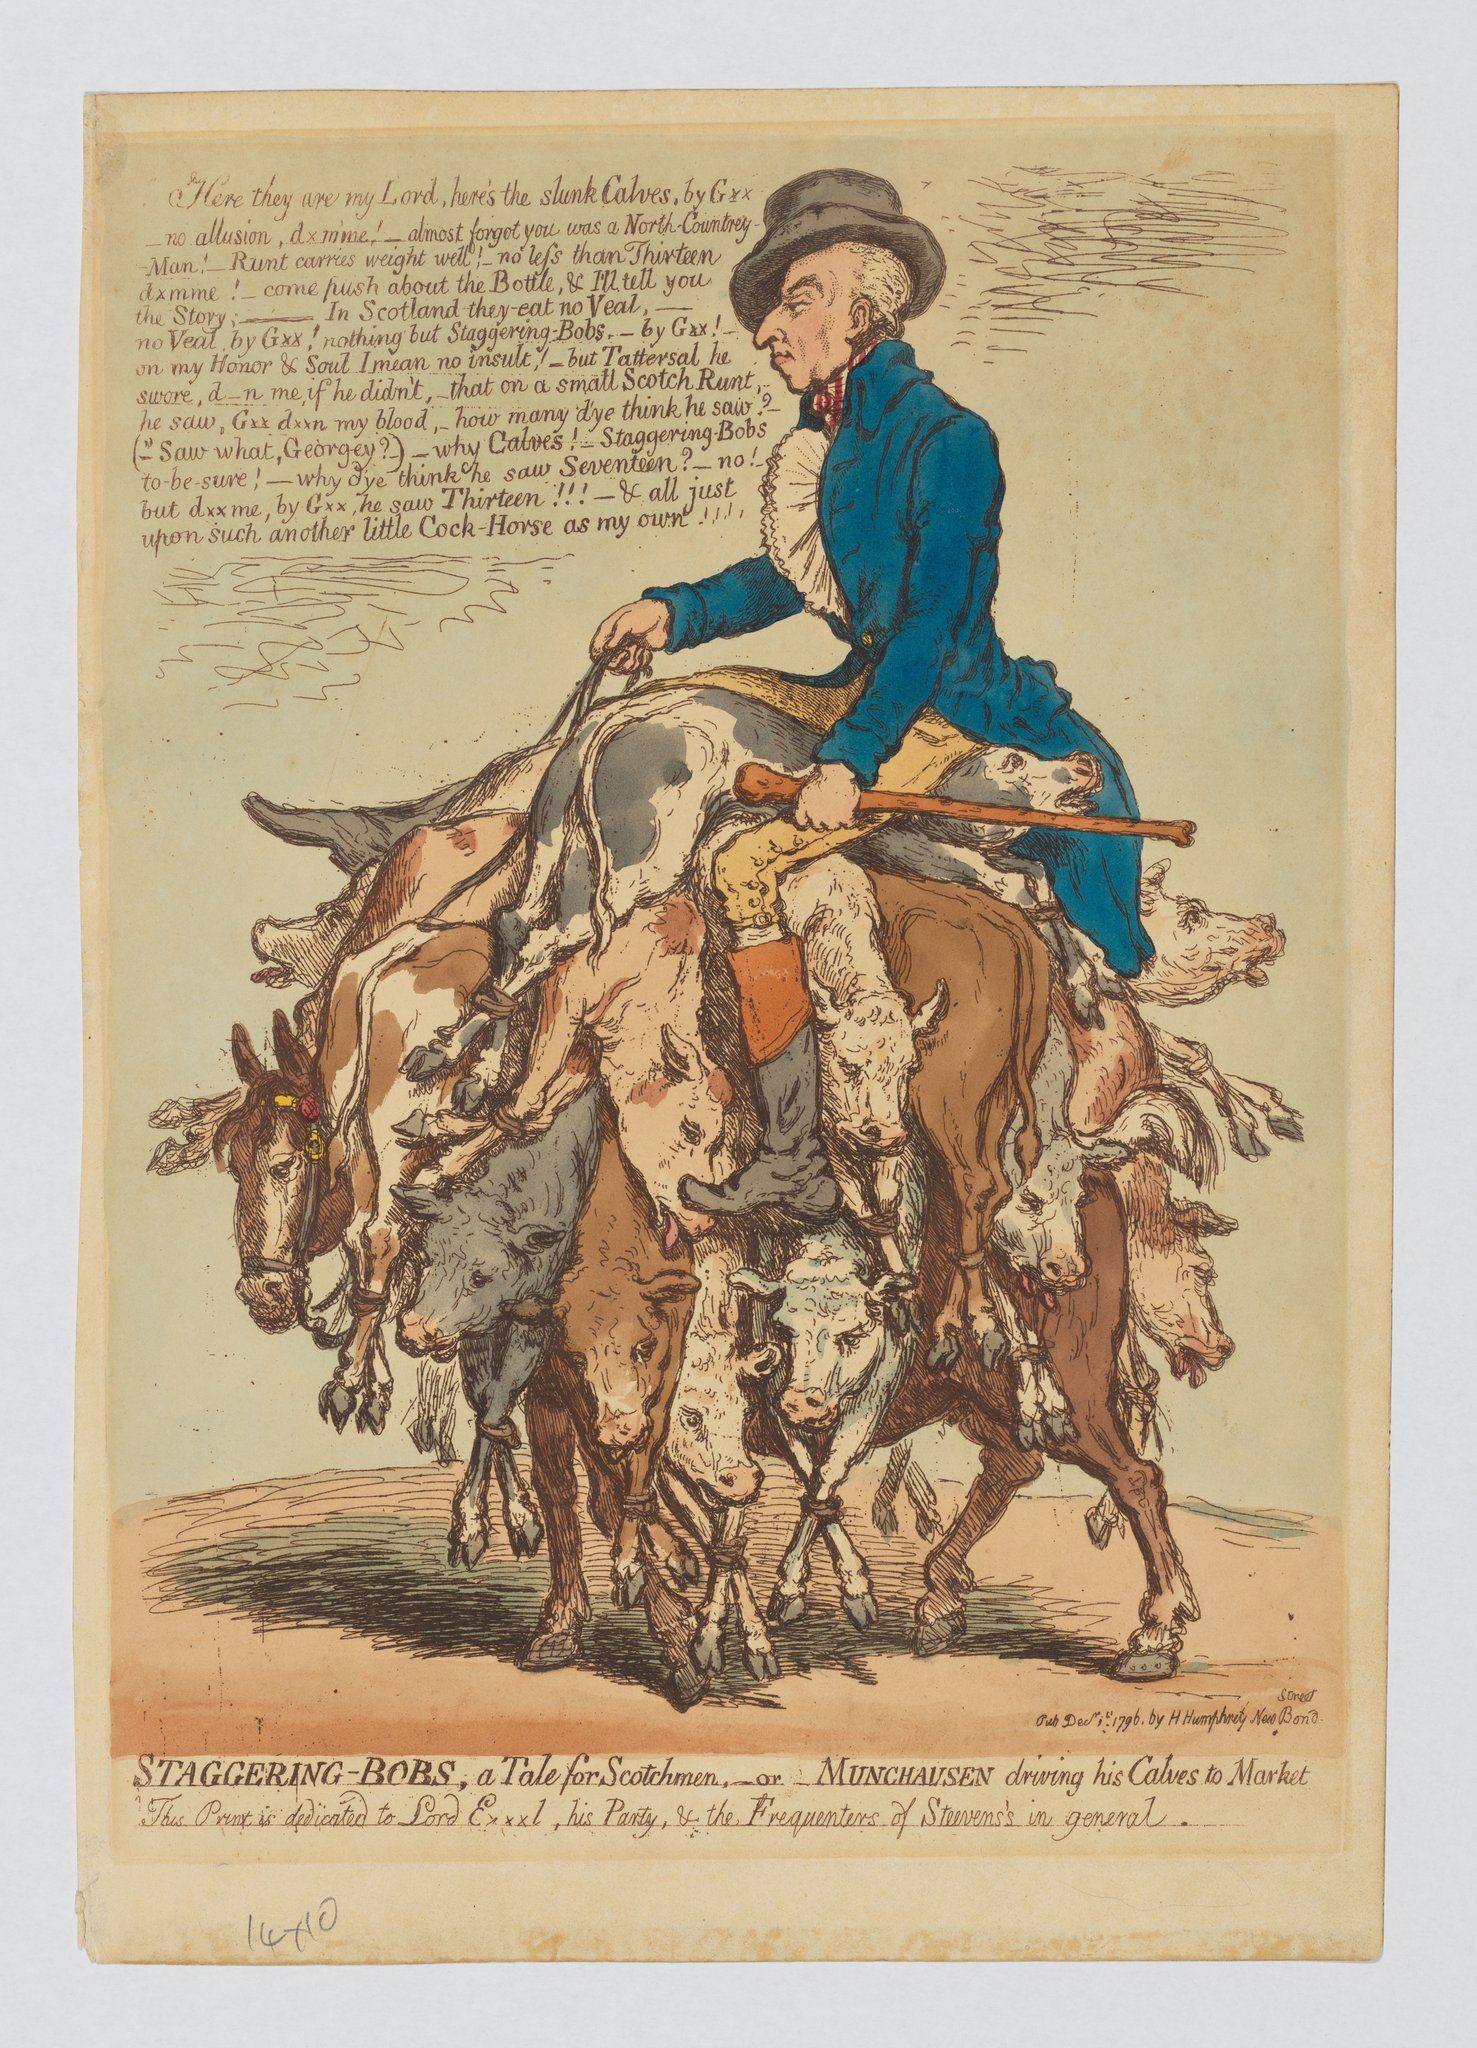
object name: print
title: Staggering-Bobs, a Tale for Scotchmen, or Munchausen Driving his Calves to Market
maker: james gillray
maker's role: artist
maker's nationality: british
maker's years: 1756-1815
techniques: etching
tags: satire,men,cows,horses